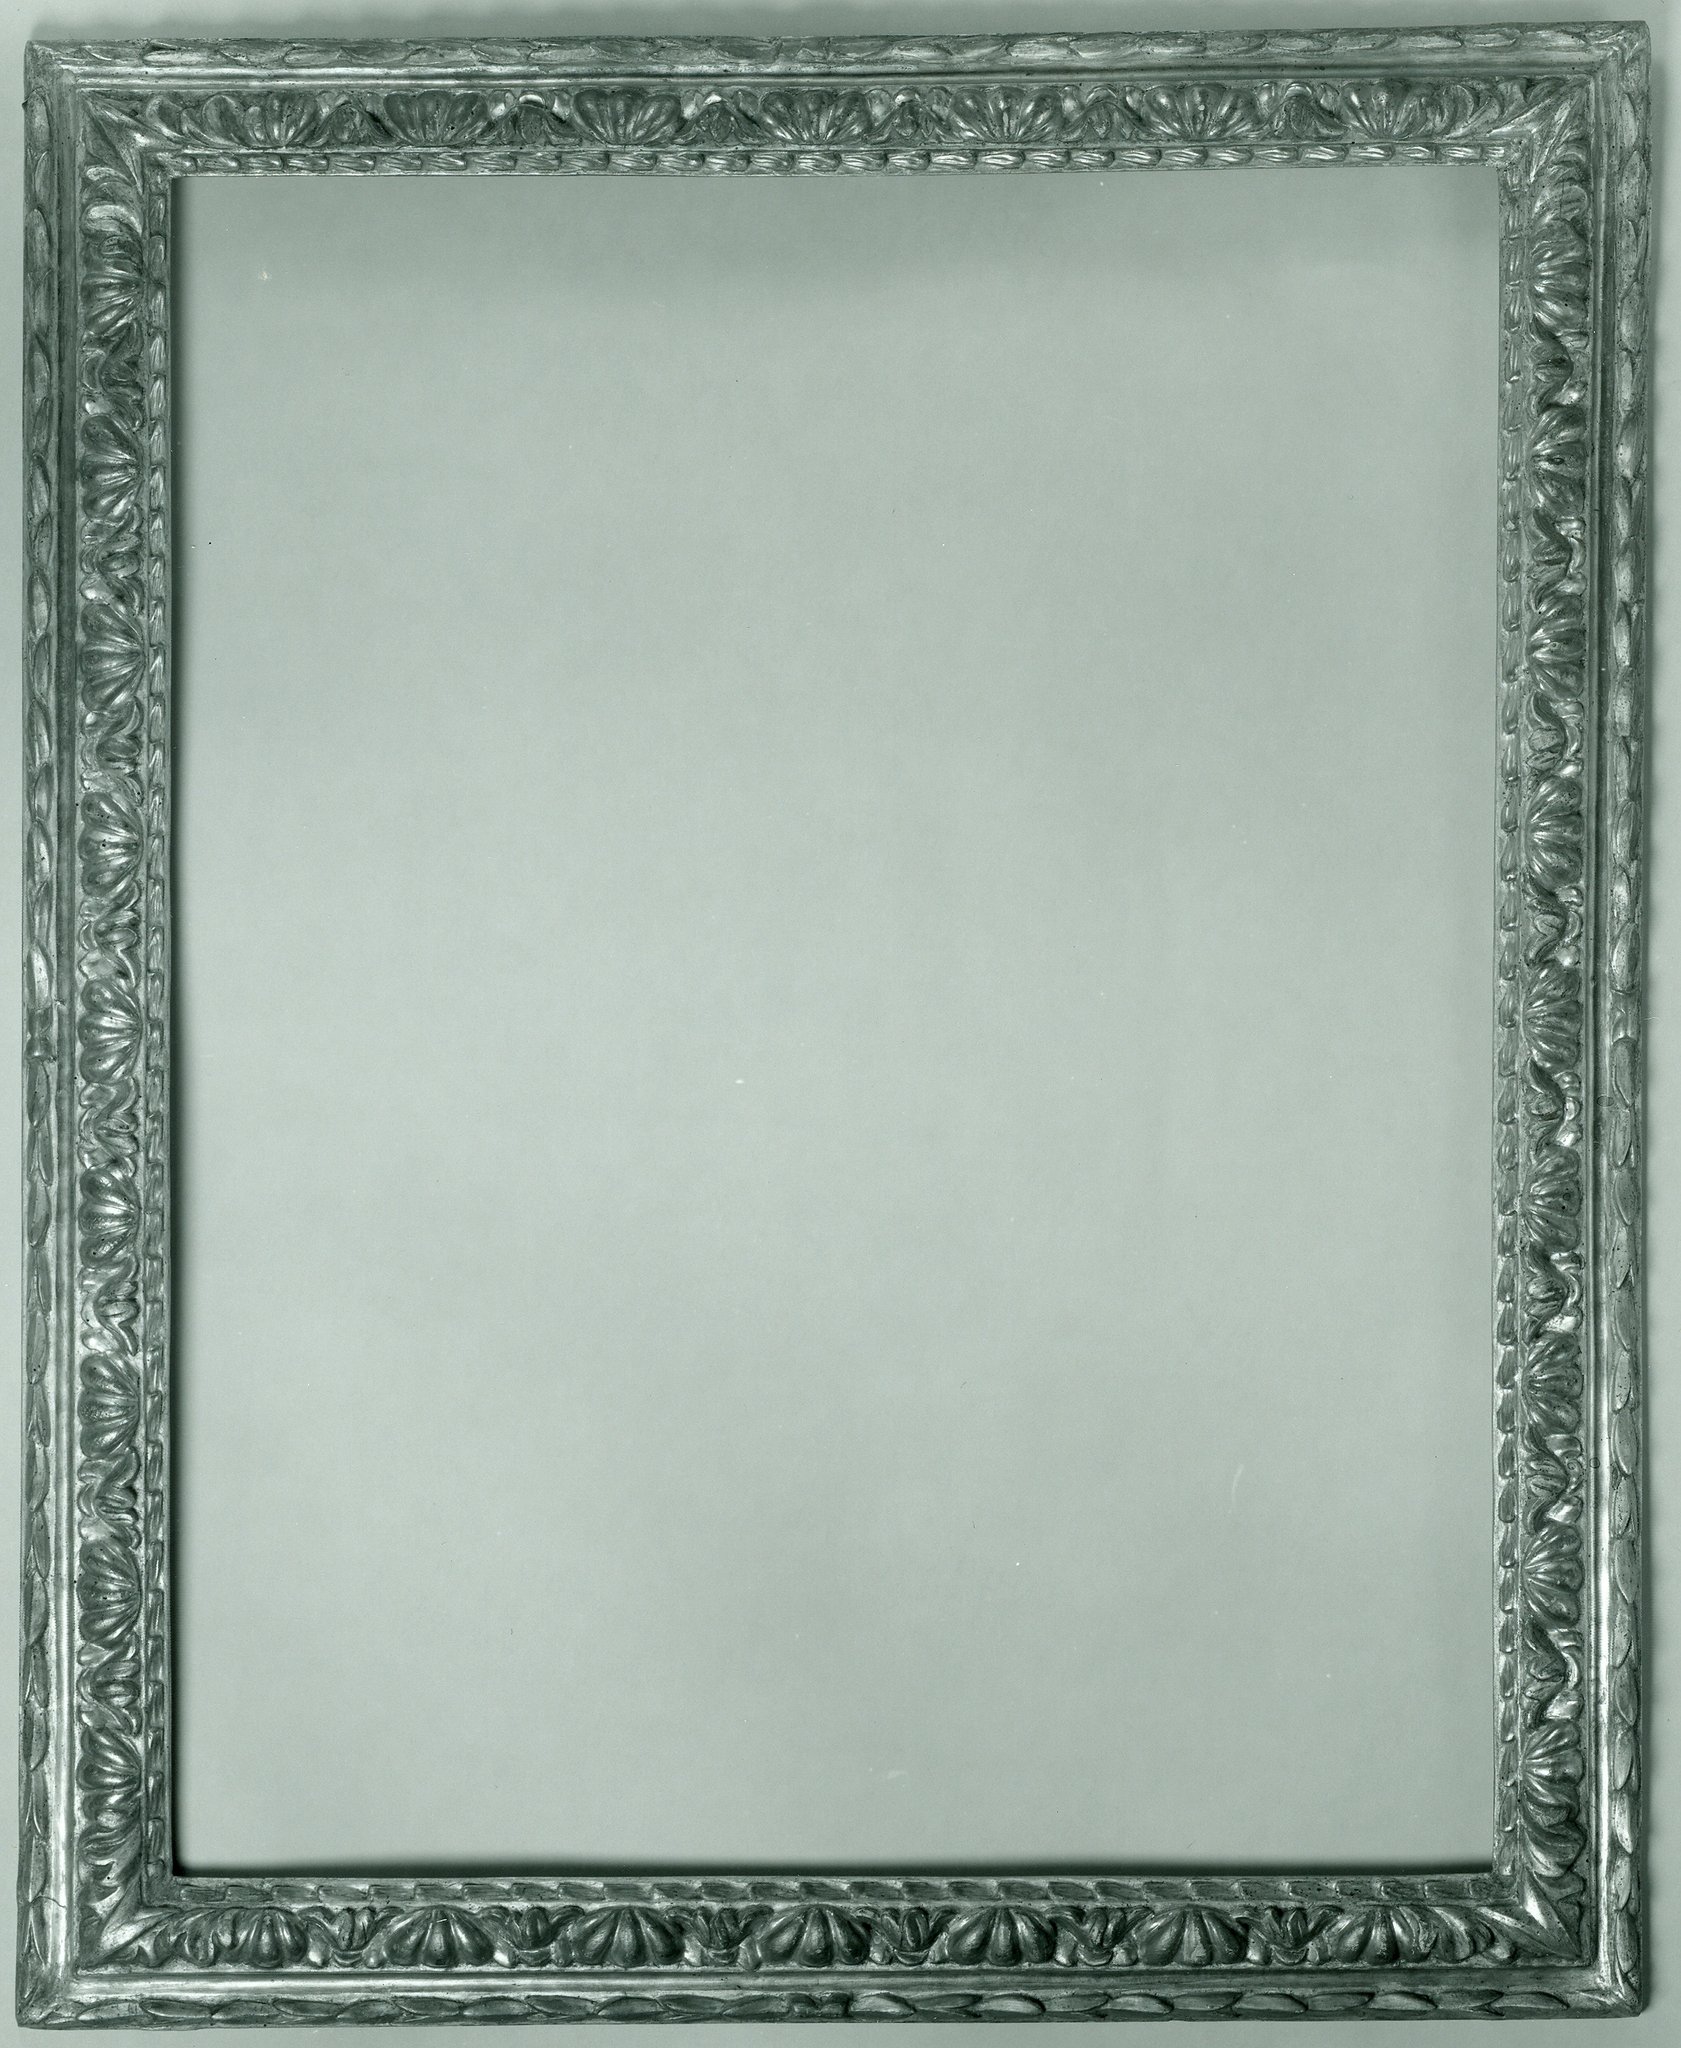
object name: frame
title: Reverse frame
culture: italian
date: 1634-1666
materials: wood